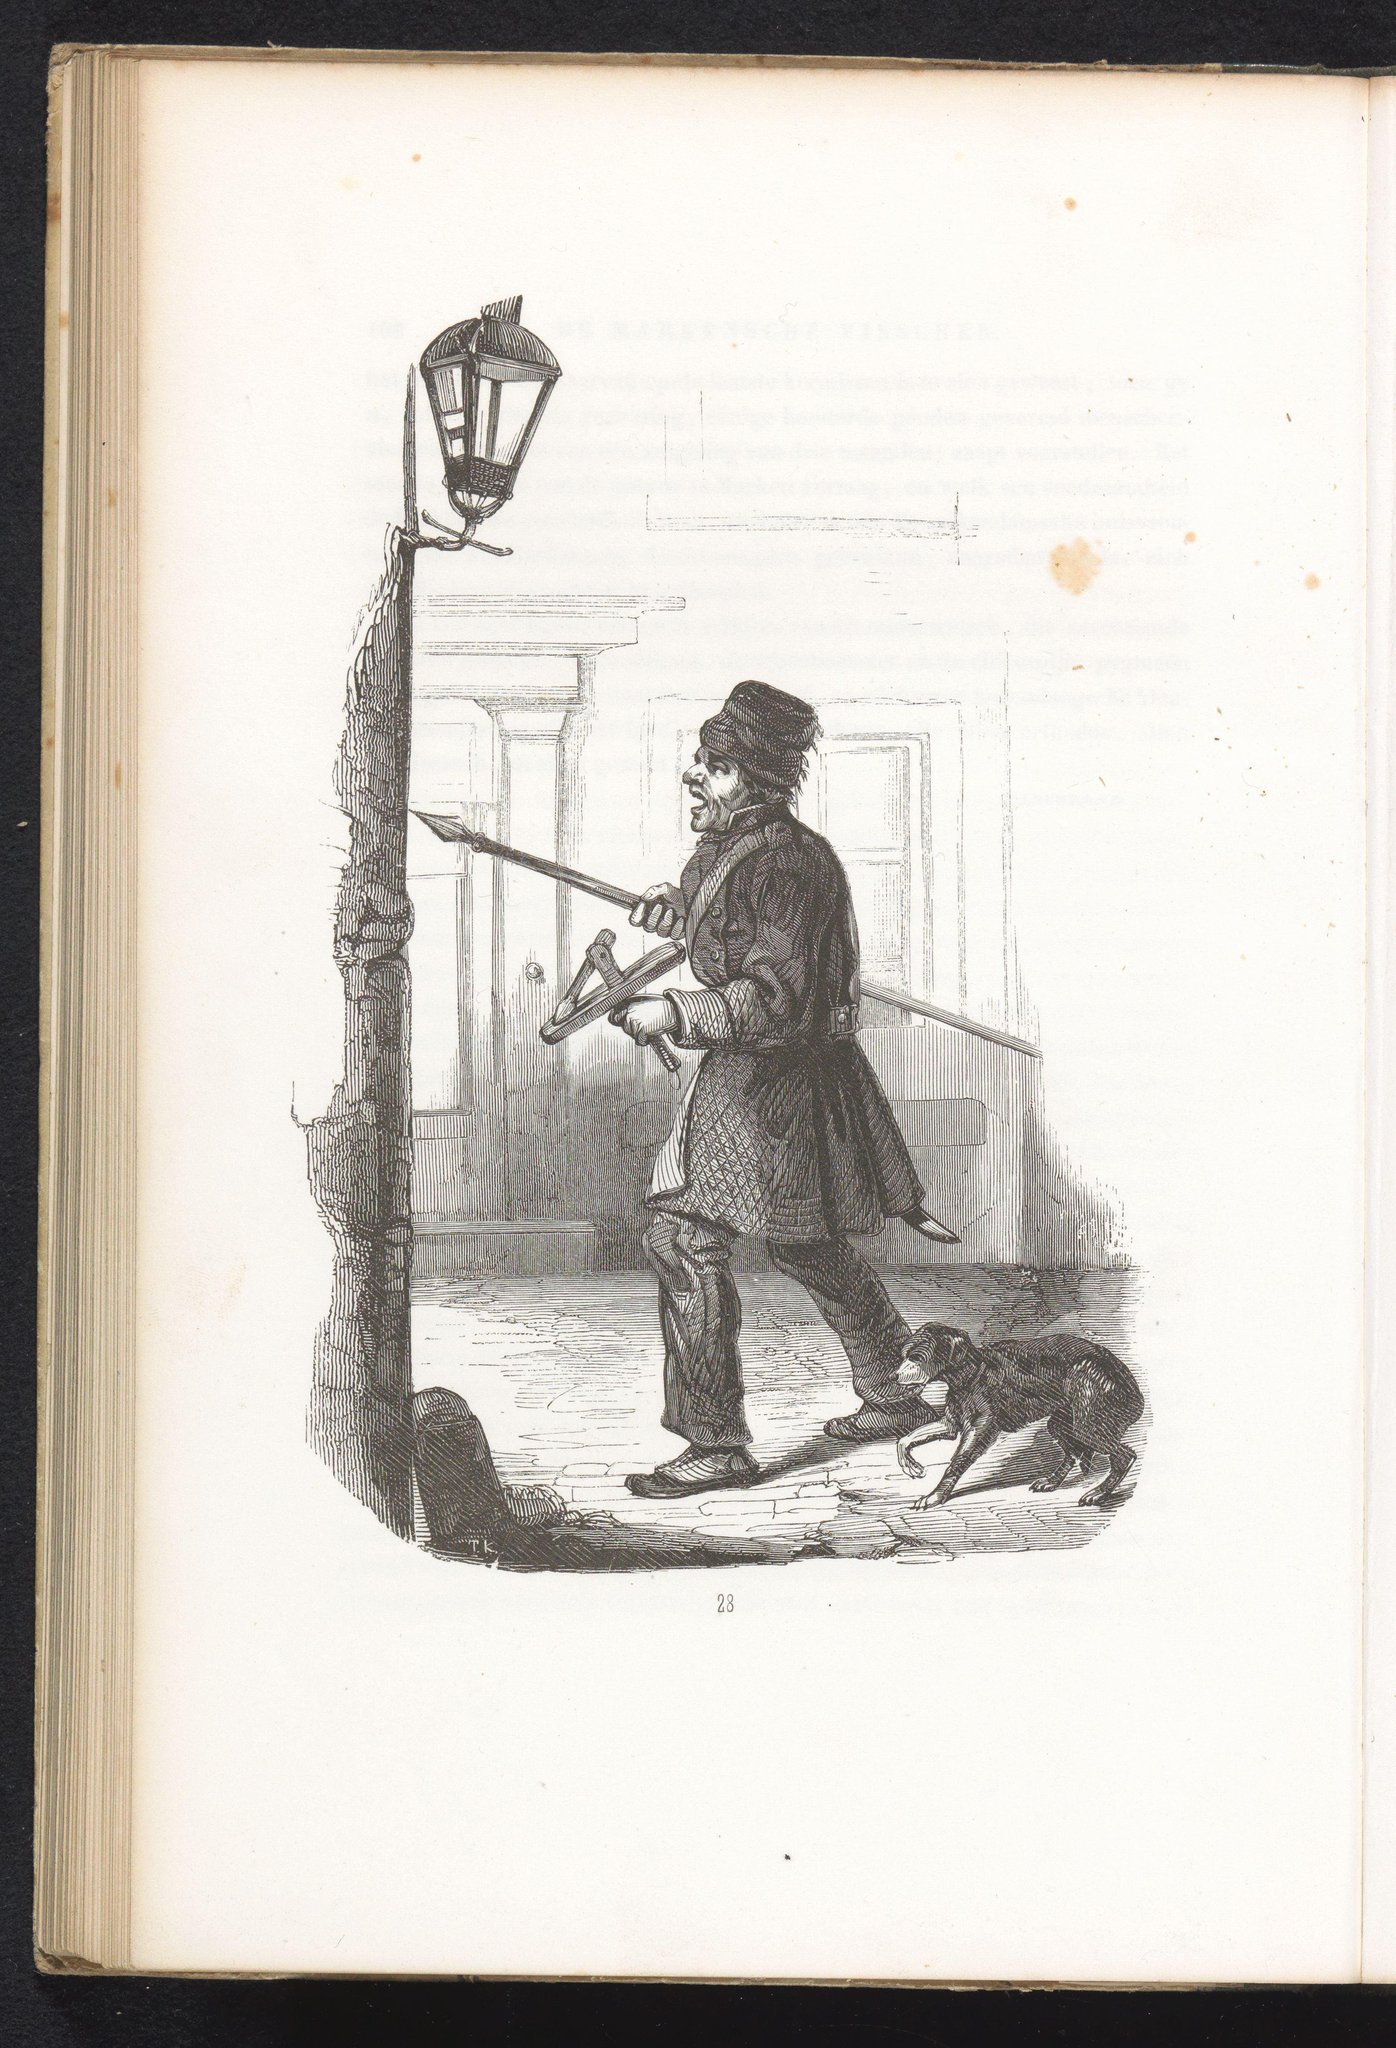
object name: book illustration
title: De klapperman van 's-Gravenhage, 1840-1841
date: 1841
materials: paper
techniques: letterpress printing, engraving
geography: the hague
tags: night patrol, professional clothes, the hague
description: De klapperman van 's-Gravenhage. Man al roepend lopend met klapper, lans en hond door een straat. Genummerd: 28. Illustratie in het boek 'De Nederlanden: karakterschetsen, kleederdrachten, houding en voorkomen van verschillende standen', een boek met karakterschetsen, beroepen en klederdrachten van Nederlandse volkstypen uit 1841.